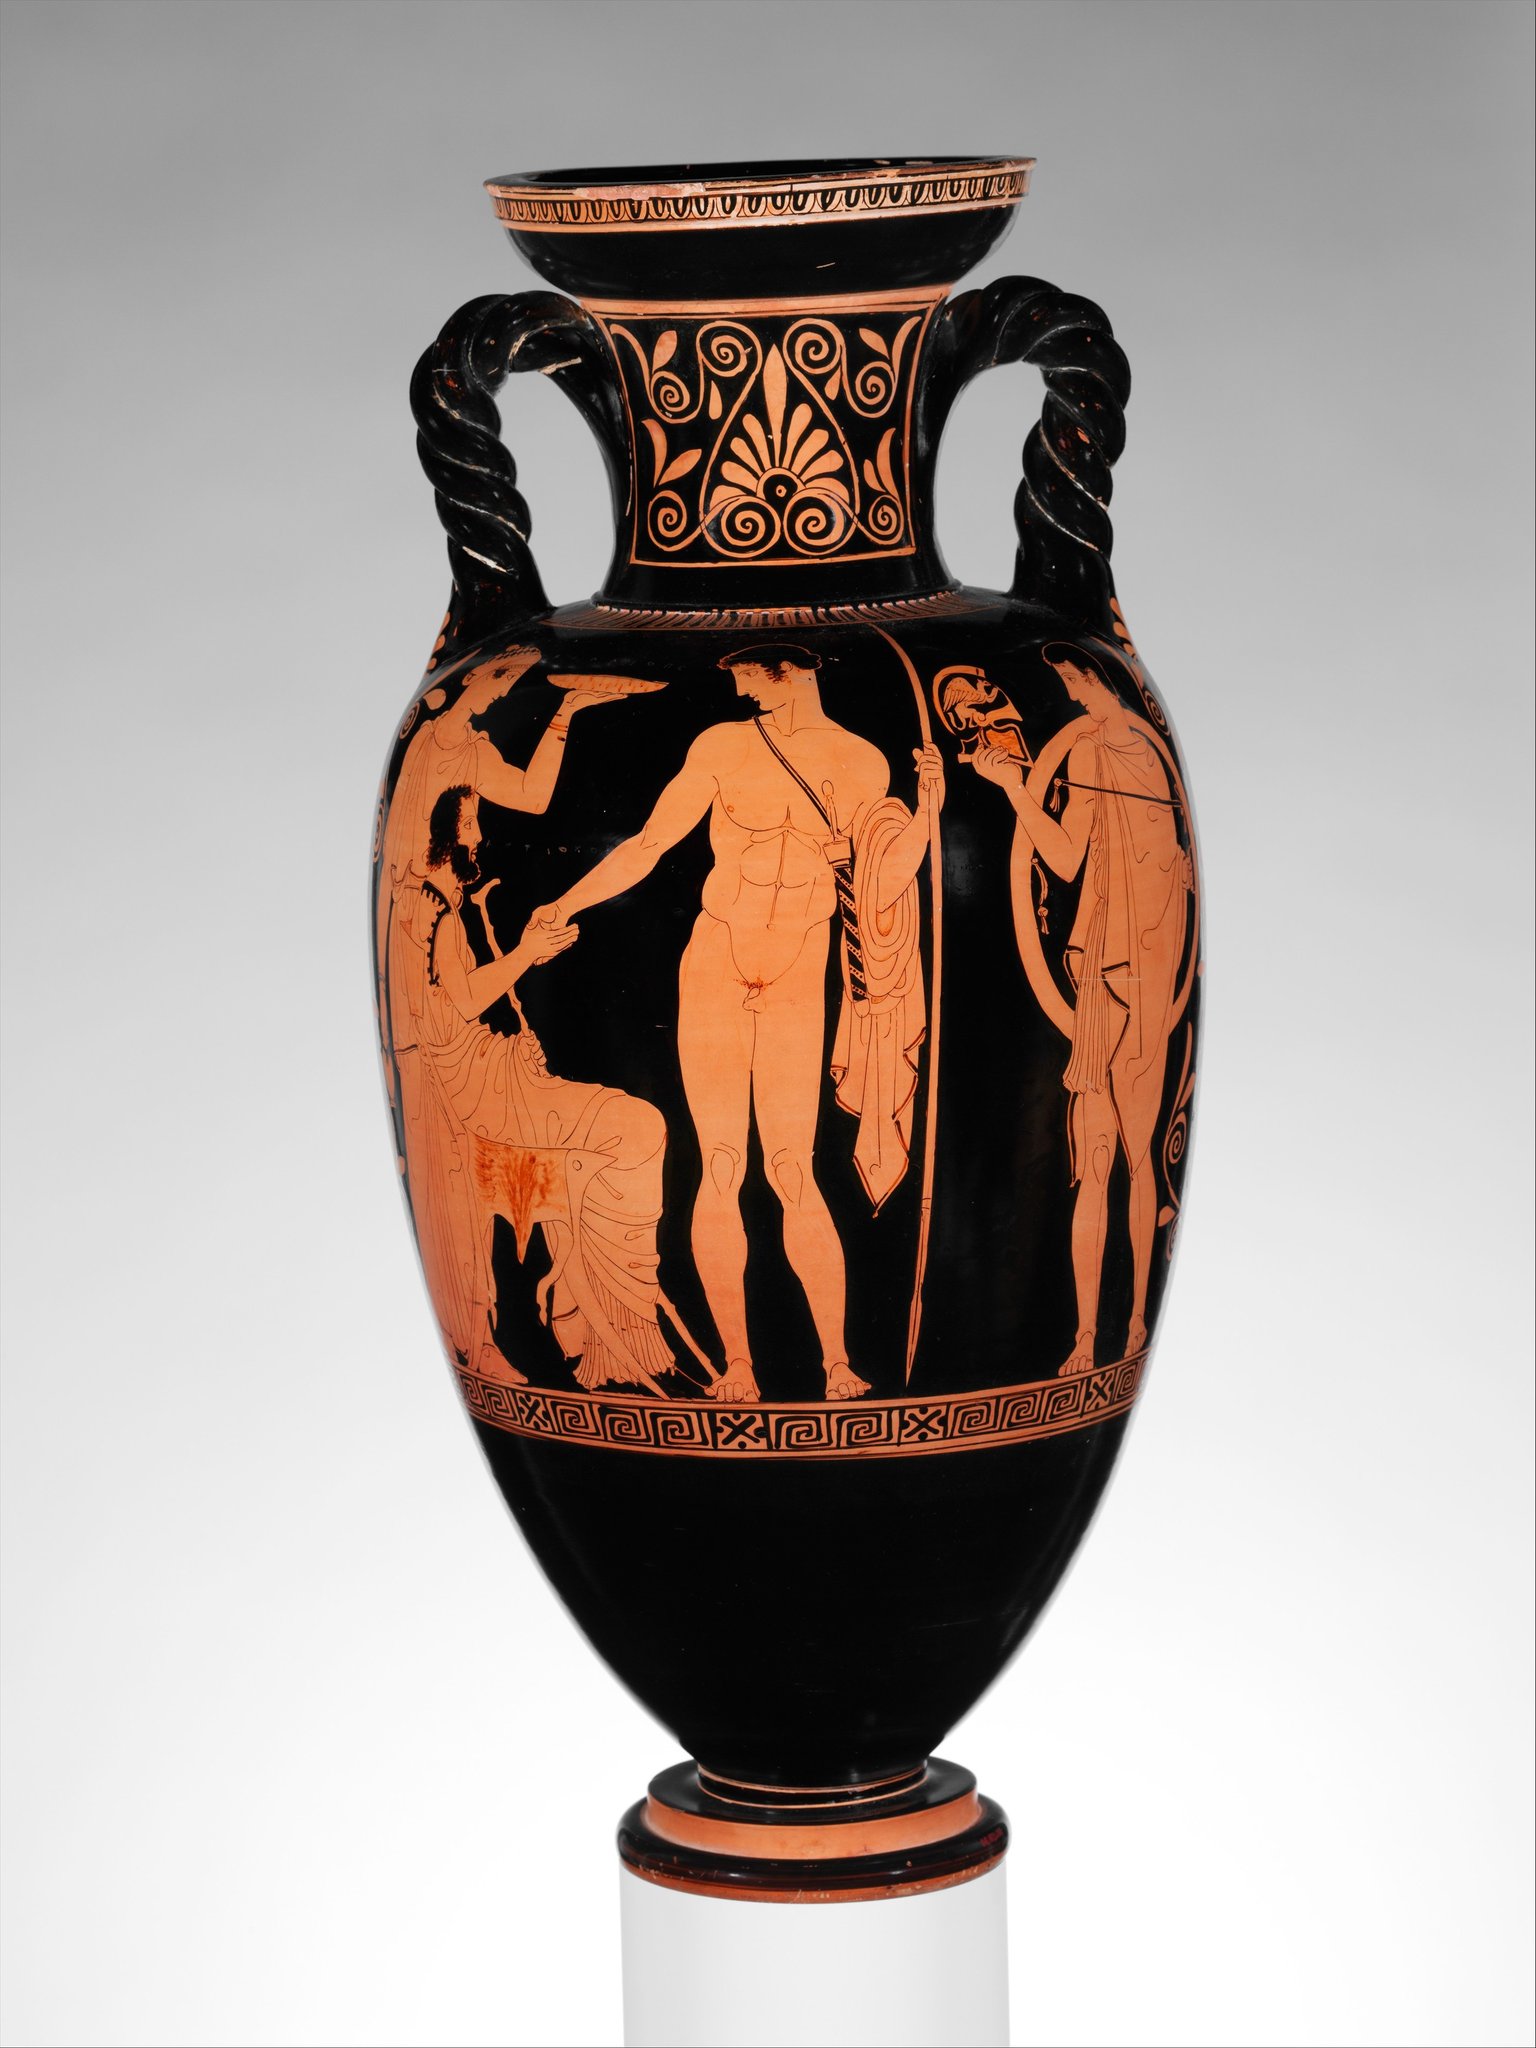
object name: neck amphora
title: Terracotta neck-amphora (jar) with twisted handles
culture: greek, attic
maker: lykaon painter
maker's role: artist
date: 440 BCE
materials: terracotta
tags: men,male nudes,women